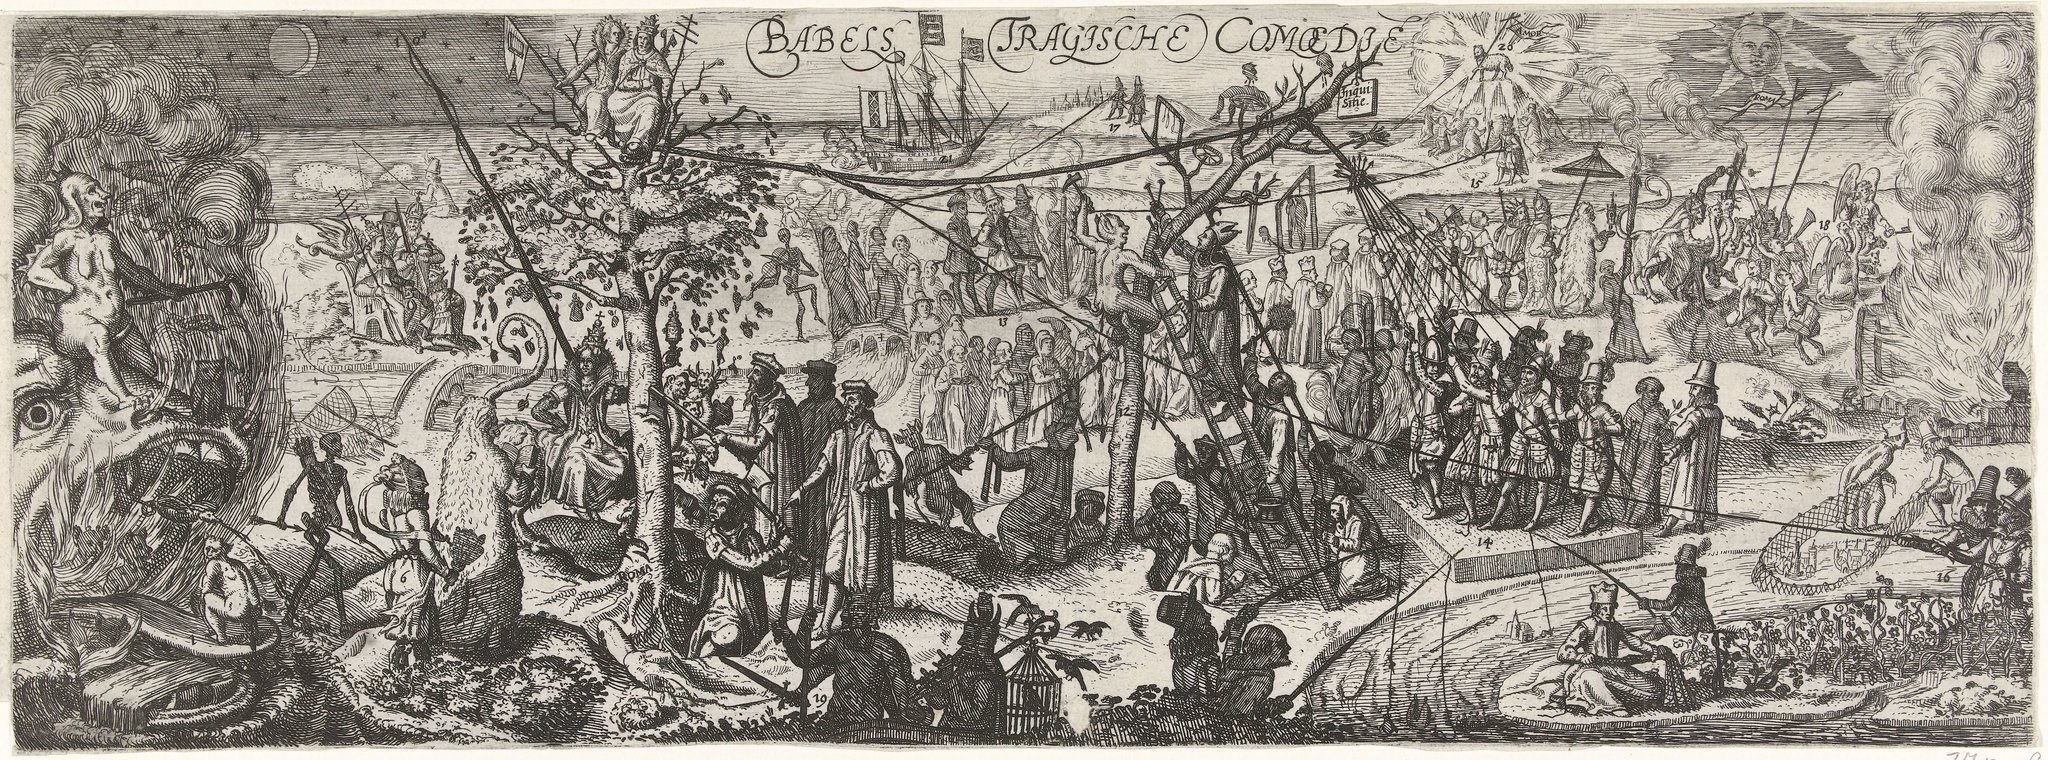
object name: cartoon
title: Babels Tragische Comoedie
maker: Anonymous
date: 1616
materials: paper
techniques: etching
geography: northern netherlands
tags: maurice (prince of orange), utrecht, the hague, antwerp, spain, priest, martin luther, jacobus i (koning van engeland), false prophets in sheep's clothing ~ parable of the good shepherd (matthew 7:15), execution of heretic, e.g. by burning at the stake, 'auto-da-fé', the scarlet woman, the whore of babylon; she is usually sitting on a scarlet beast with seven heads and ten horns, procession ~ christian religion, the roman catholic church vs. protestantism; (reformation and counter reformation)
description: Spotprent op de misbruiken van de Roomse kerk, 1616. Links de hellemond met duivels. Een valse profeet in schaapskleren predikt uit een boek. Hervormers Calvijn en Luther hakken een boom om waarin de paus en de Hoer van Babylon zitten. Aan deze boom en aan een tweede boom gemerkt Inquisitie trekt met touwen een groep protestantse vorsten waaronder Maurits en Jacobus I van Engeland. Met ketterverbrandingen. Op de achtergrond een processie geleid door de Hoer van Babylon met pauselijke driekroon gezeten op het zevenkoppig beest, duivels, gevolgd door de valse profeet, wereldse vorsten en katholieke geestelijken. Rechts vissen katholieken kostbaarheden uit een vijver. Met veel andere details en prominenten waaronder Jan Neyen, Johannes Wtenbogaert en Jacobus Taurinus. De prent behoort in het begeleidende pamflet (RP-P-1957-7B).